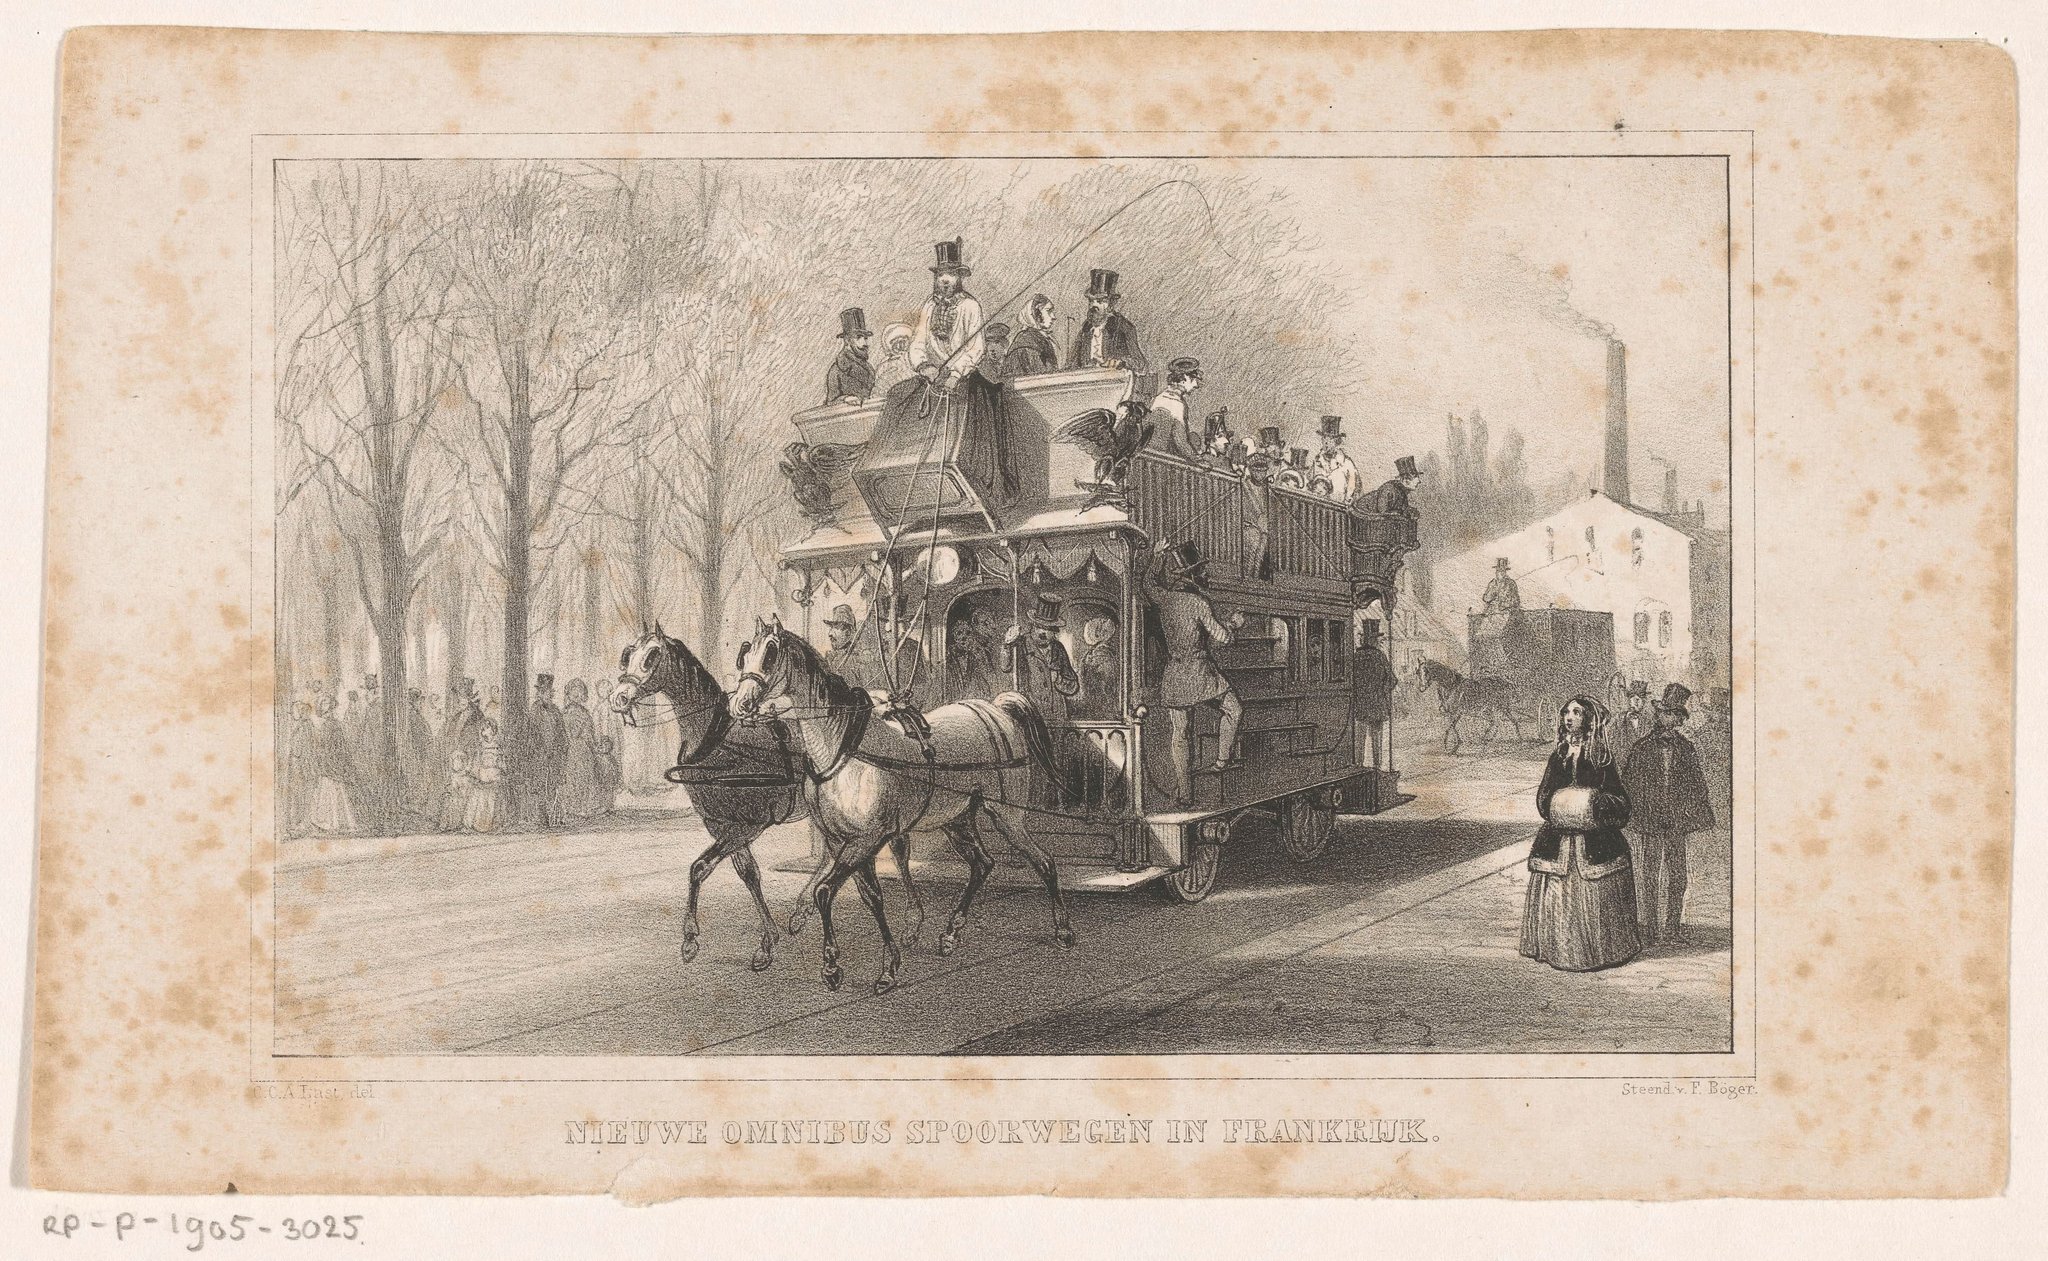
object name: print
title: Nieuwe Omnibus Spoorwegen in Frankrijk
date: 1846-1876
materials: paper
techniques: lithograph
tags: diligence, omnibus, horse-tram, smoke-stack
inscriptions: collector's mark: Lugt 2228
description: De tram is volgeladen en wordt voortgetrokken door twee paarden. In de achtergrond nog een paardentram en een gebouw met een rokende schoorsteen.